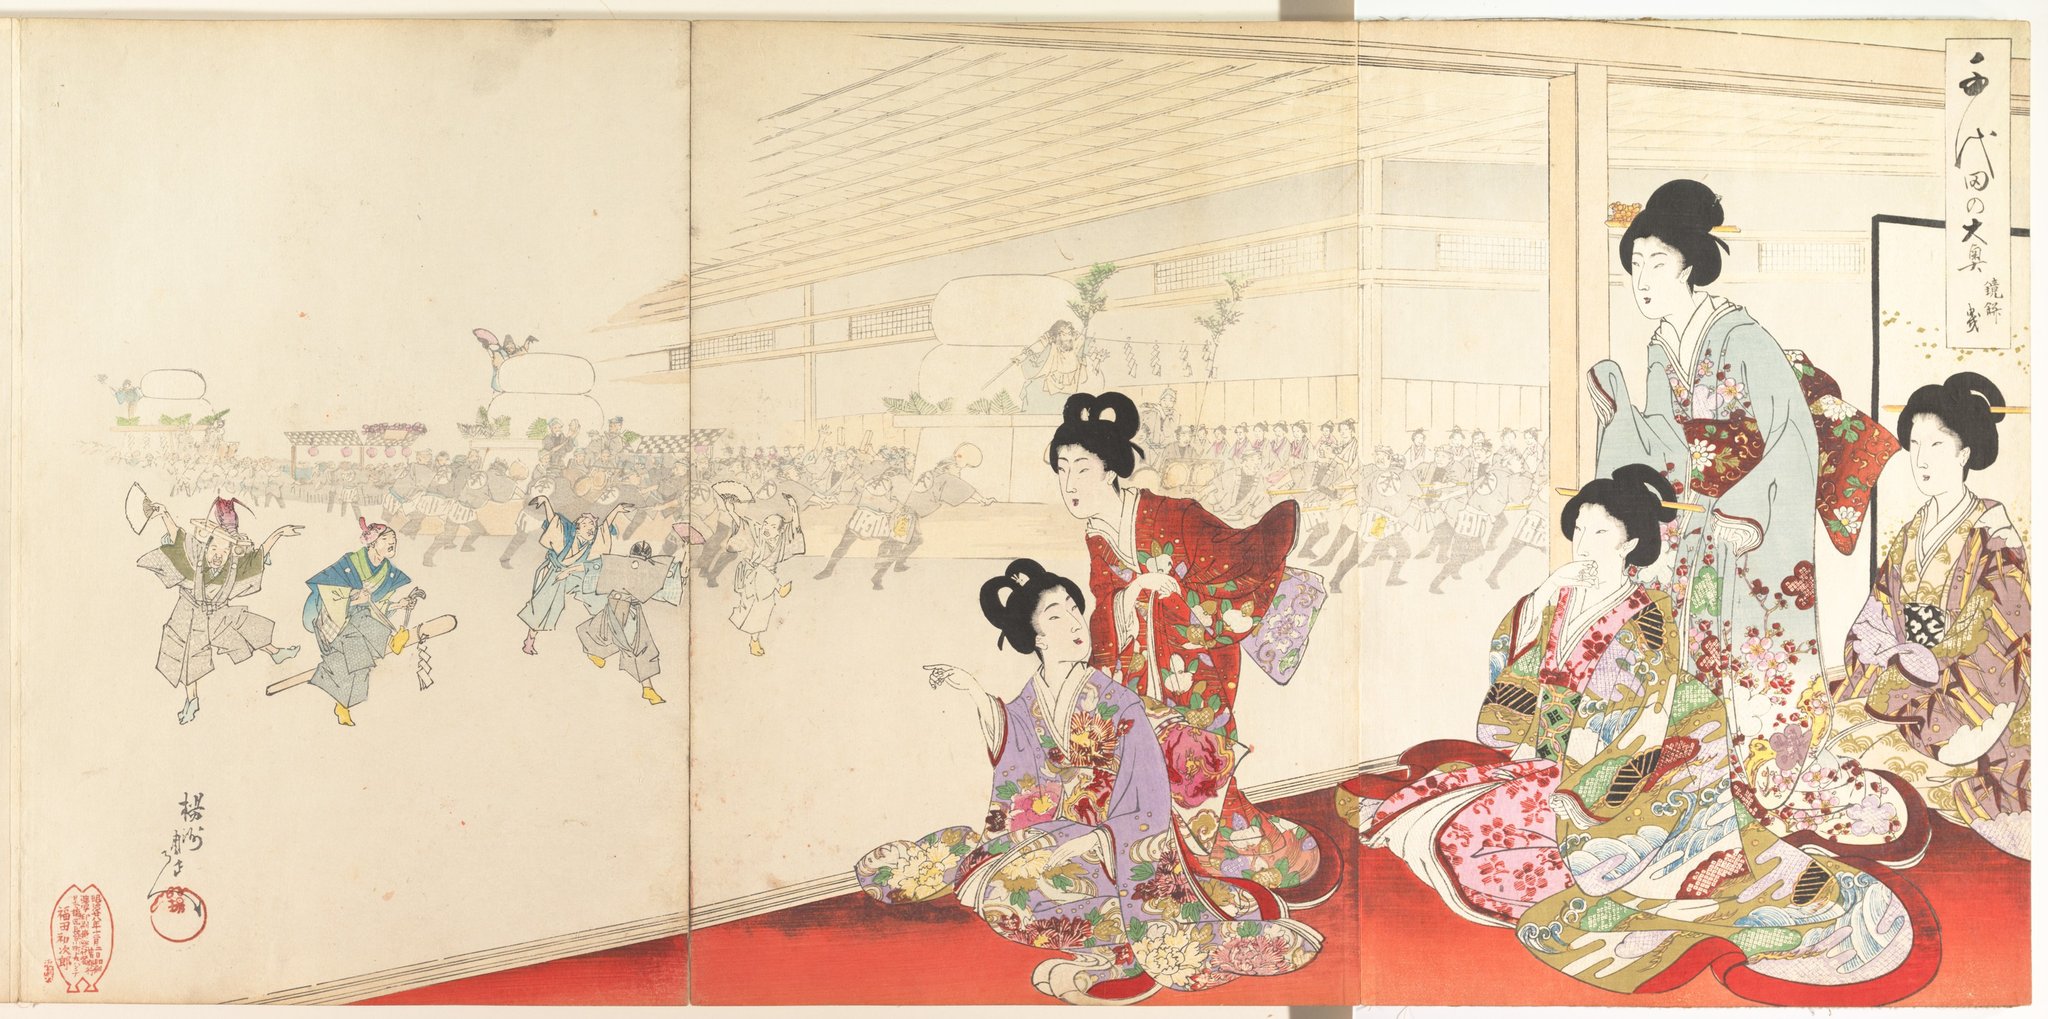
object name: print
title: Chiyoda Castle (Album of Women)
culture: japanese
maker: yōshū (hashimoto) chikanobu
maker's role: artist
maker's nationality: japanese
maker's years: 1838-1912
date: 1895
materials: ink, paper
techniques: woodblock print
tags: men,women,spectators